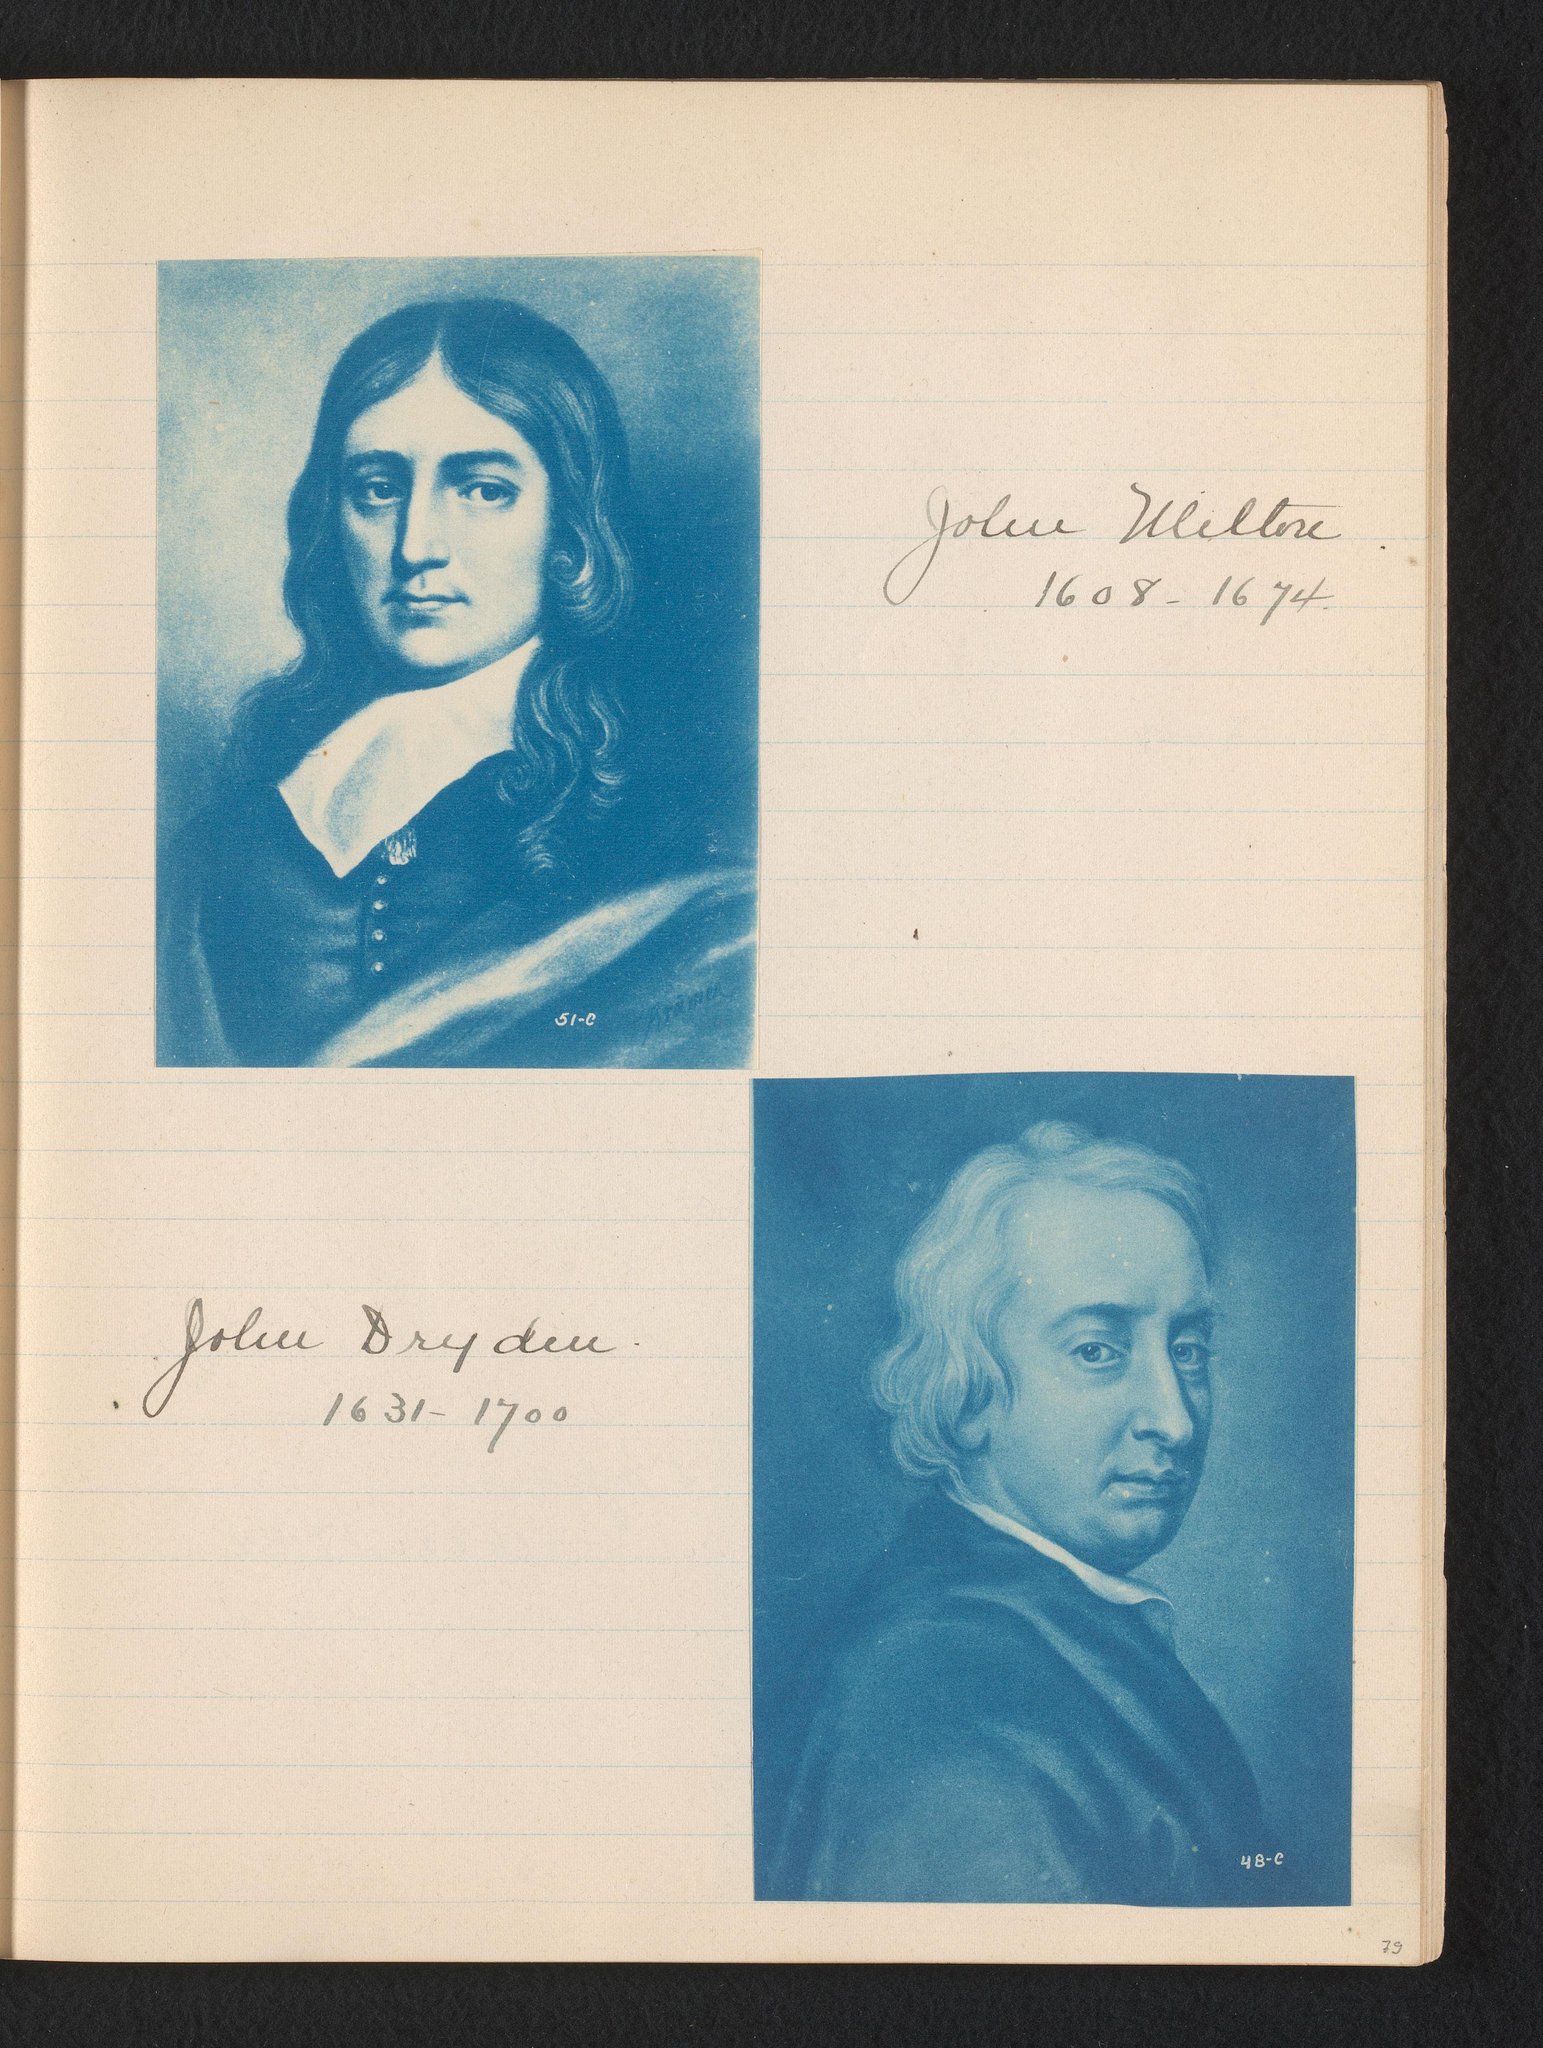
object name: photograph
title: Twee fotoreproductie van geschilderde portretten van John Milton en John Dryden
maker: Anonymous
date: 1901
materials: paper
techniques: cyanotype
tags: england, london, john dryden, john milton, historical persons, writer, poet, author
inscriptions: inscription: ‘John Milton/ 1608-1674/ John Dryden/ 1631-1700’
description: Deze foto's maken deel uit van een album.